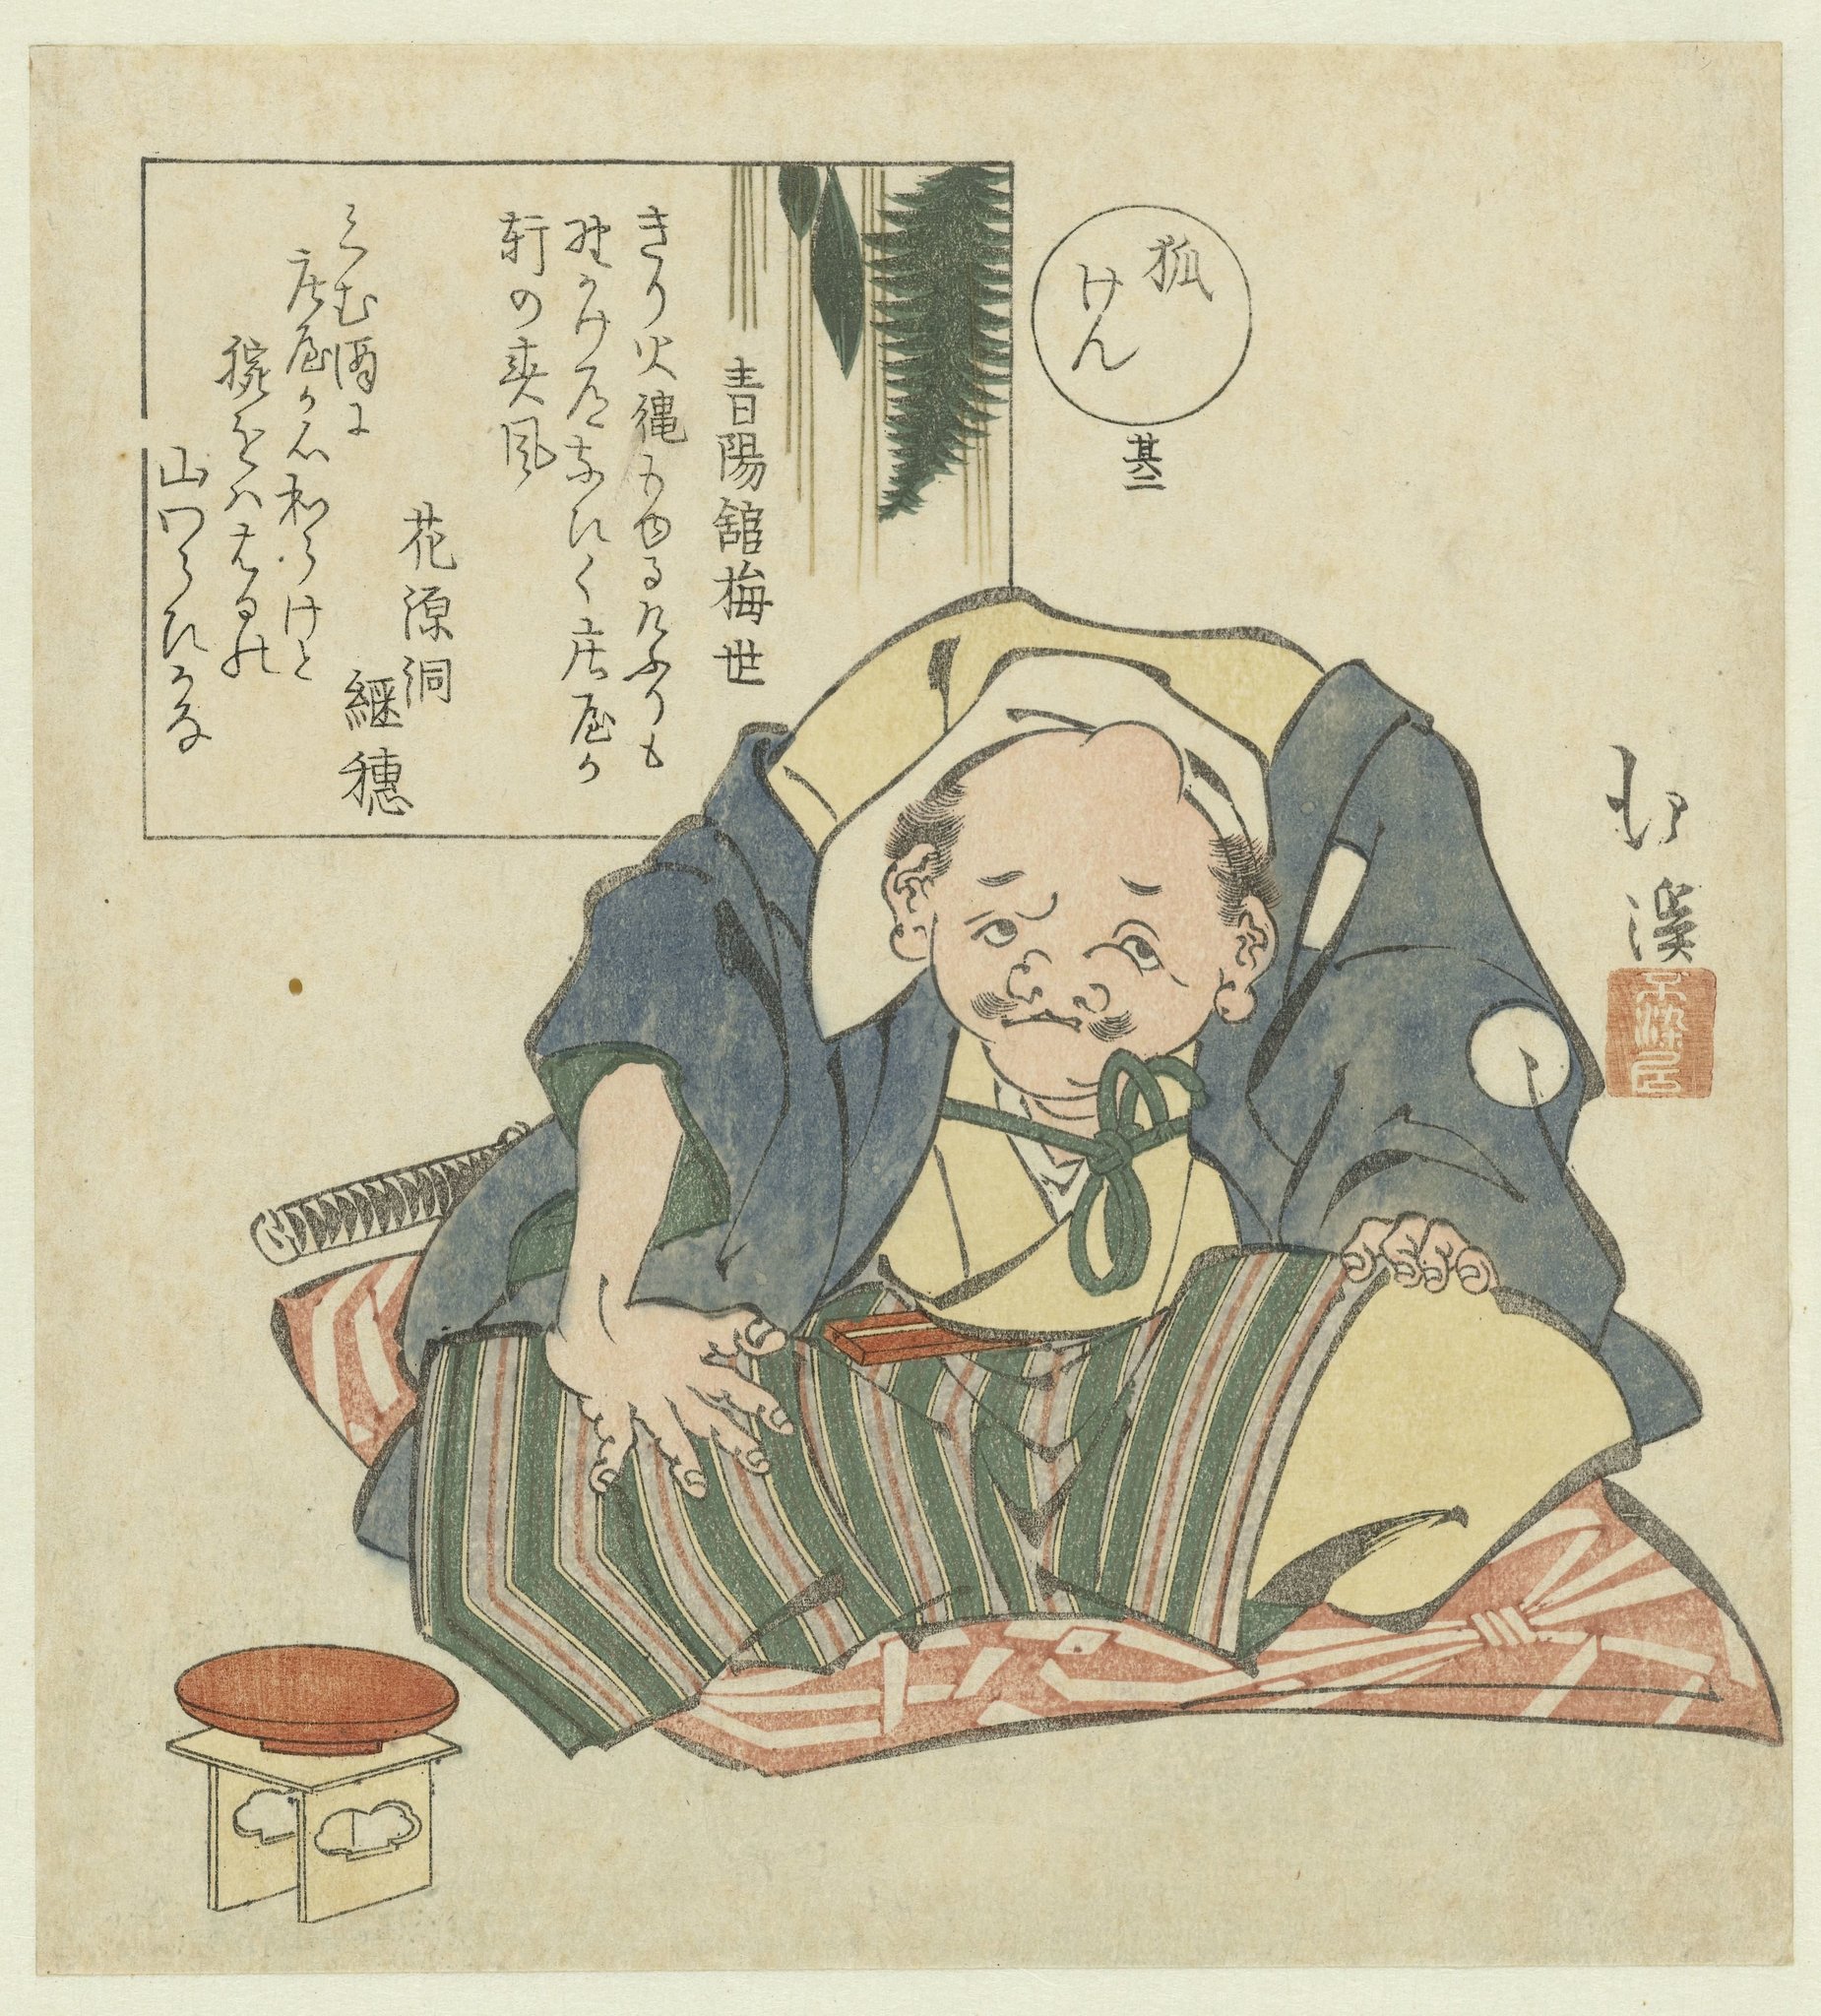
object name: surimono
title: Sono ni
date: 1830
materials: paper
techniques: woodcut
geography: japan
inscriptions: collector's mark, verso, stamped: Lugt 2228, collector's mark, passe-partout, bottom left, printed: JABdH with a rooster.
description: Een surimono is een luxe uitgevoerde prent waarop beeld met één of meerdere gedichten gecombineerd is. Bij het drukken van een surimono werd vaak gebruik gemaakt van dikker papier, blinddruk en metaal pigmenten, zoals koper- en zilverpoeder. De prenten werden vaak in opdracht van dichters gemaakt en als exclusief geschenk aan vrienden en relaties gegeven.